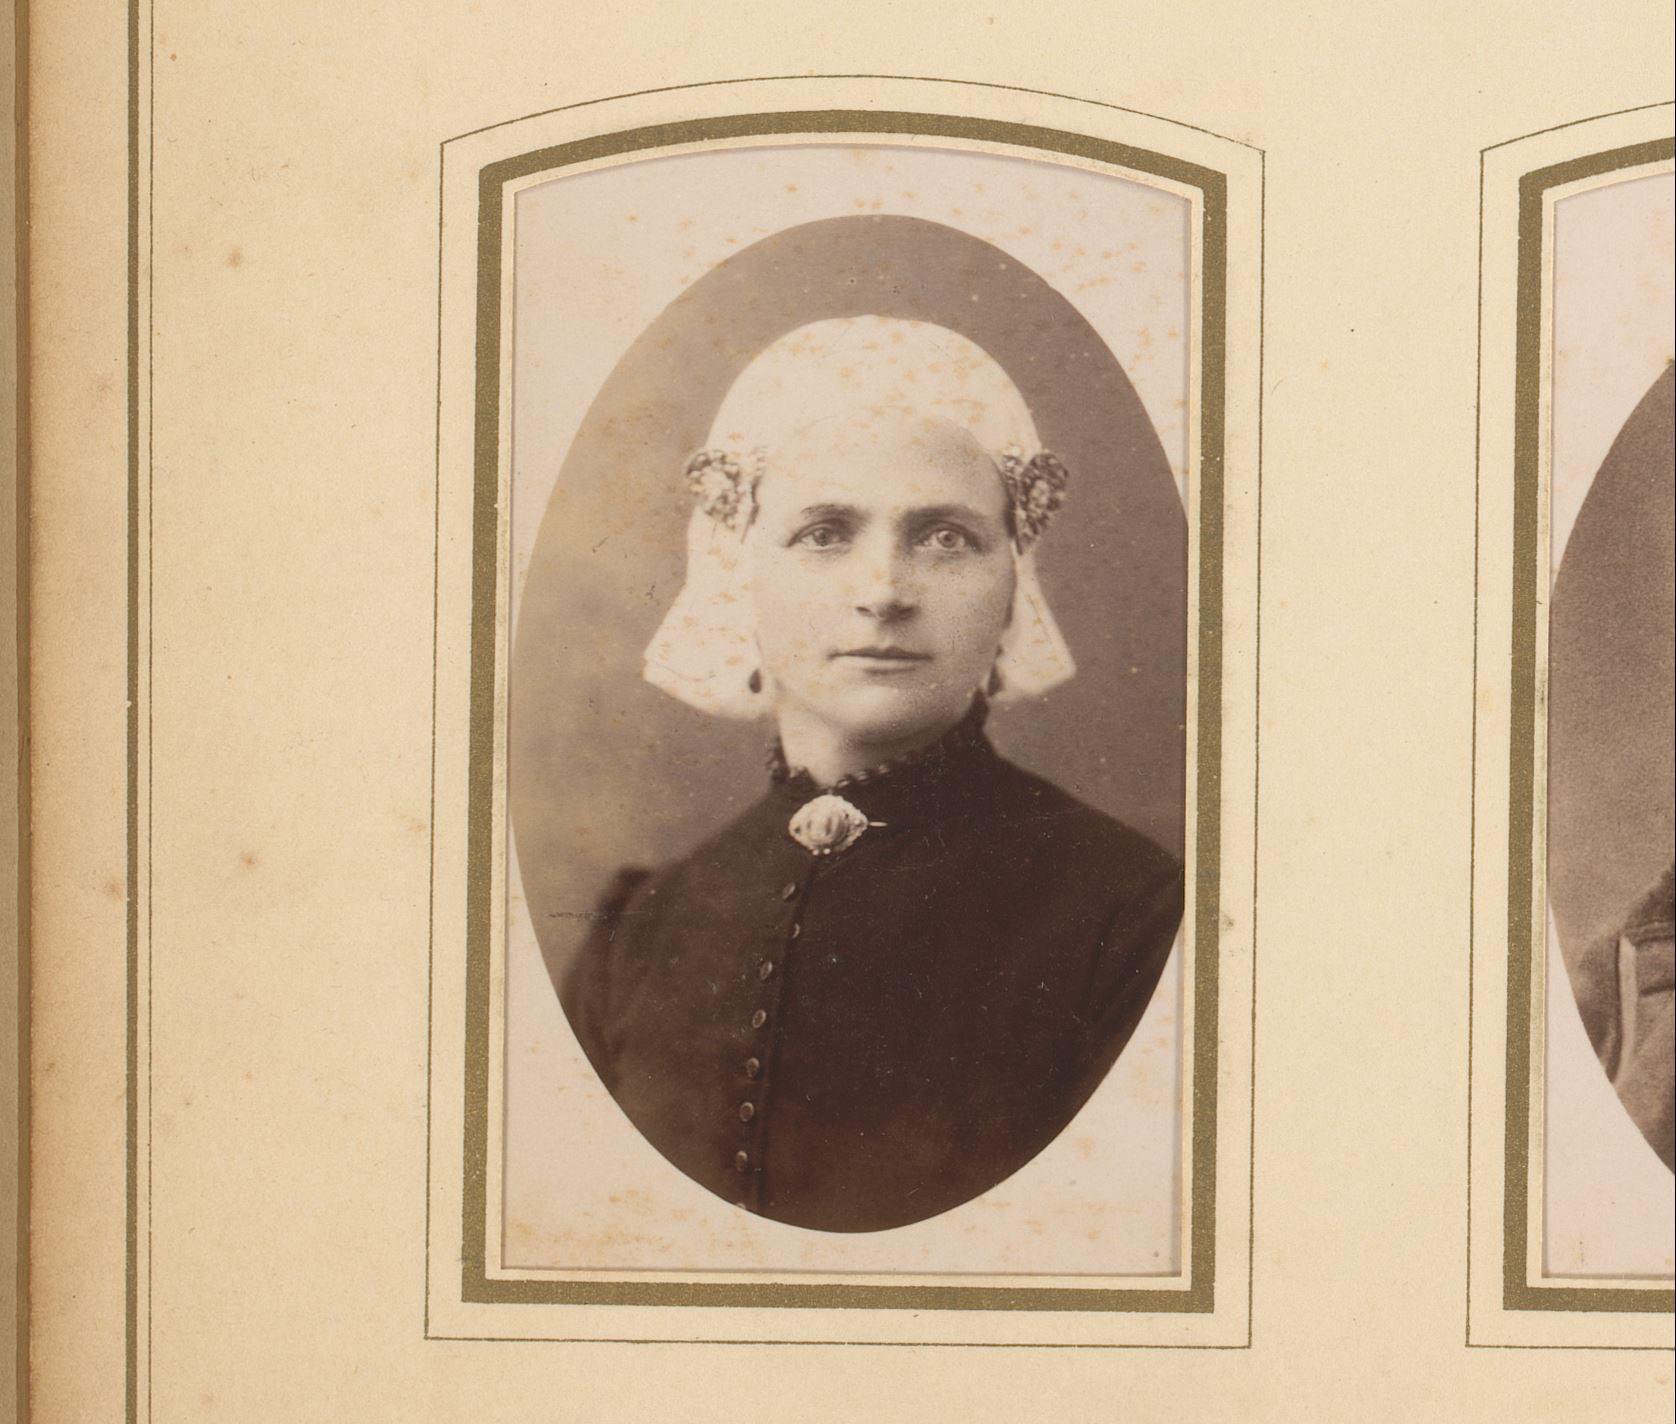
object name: album leaf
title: Portret van een jonge vrouw met witte klederdrachtmuts en oorijzers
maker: andries antonius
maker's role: sculptor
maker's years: 1853-1905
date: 1860-1900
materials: cardboard, photographic support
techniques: albumen print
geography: leeuwarden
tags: historical persons - bb - woman, head-gear: cap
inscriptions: inscription: ‘Photographie/ Instantanée/ A. Antonius/ Leeuwarden/ G. Hoogstraat’